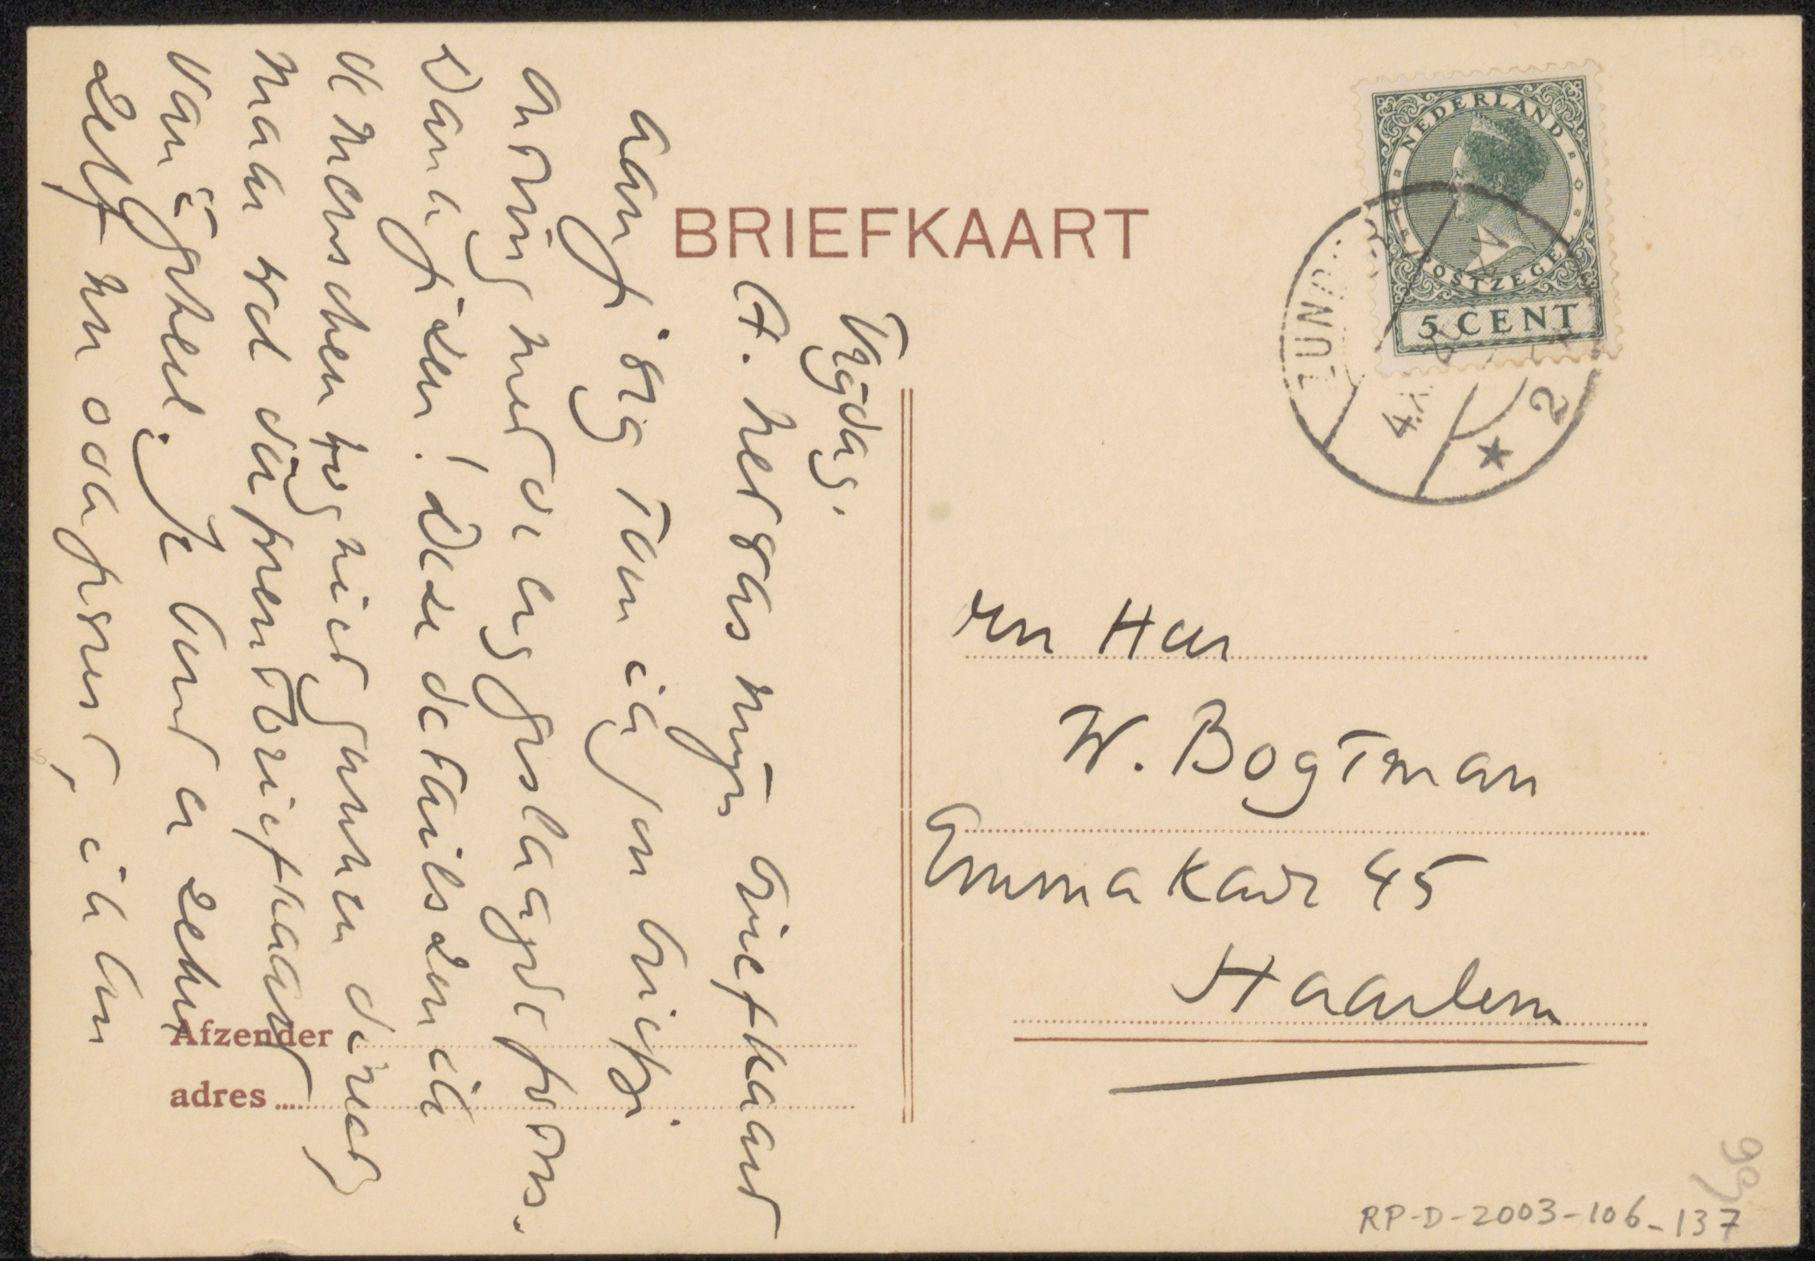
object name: postcard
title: Briefkaart aan Willem Bogtman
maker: richard nicolaüs roland holst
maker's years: 1868-1938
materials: cardboard, ink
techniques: pen, writing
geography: zundert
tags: haarlem, willem bogtman, photography, cinematography